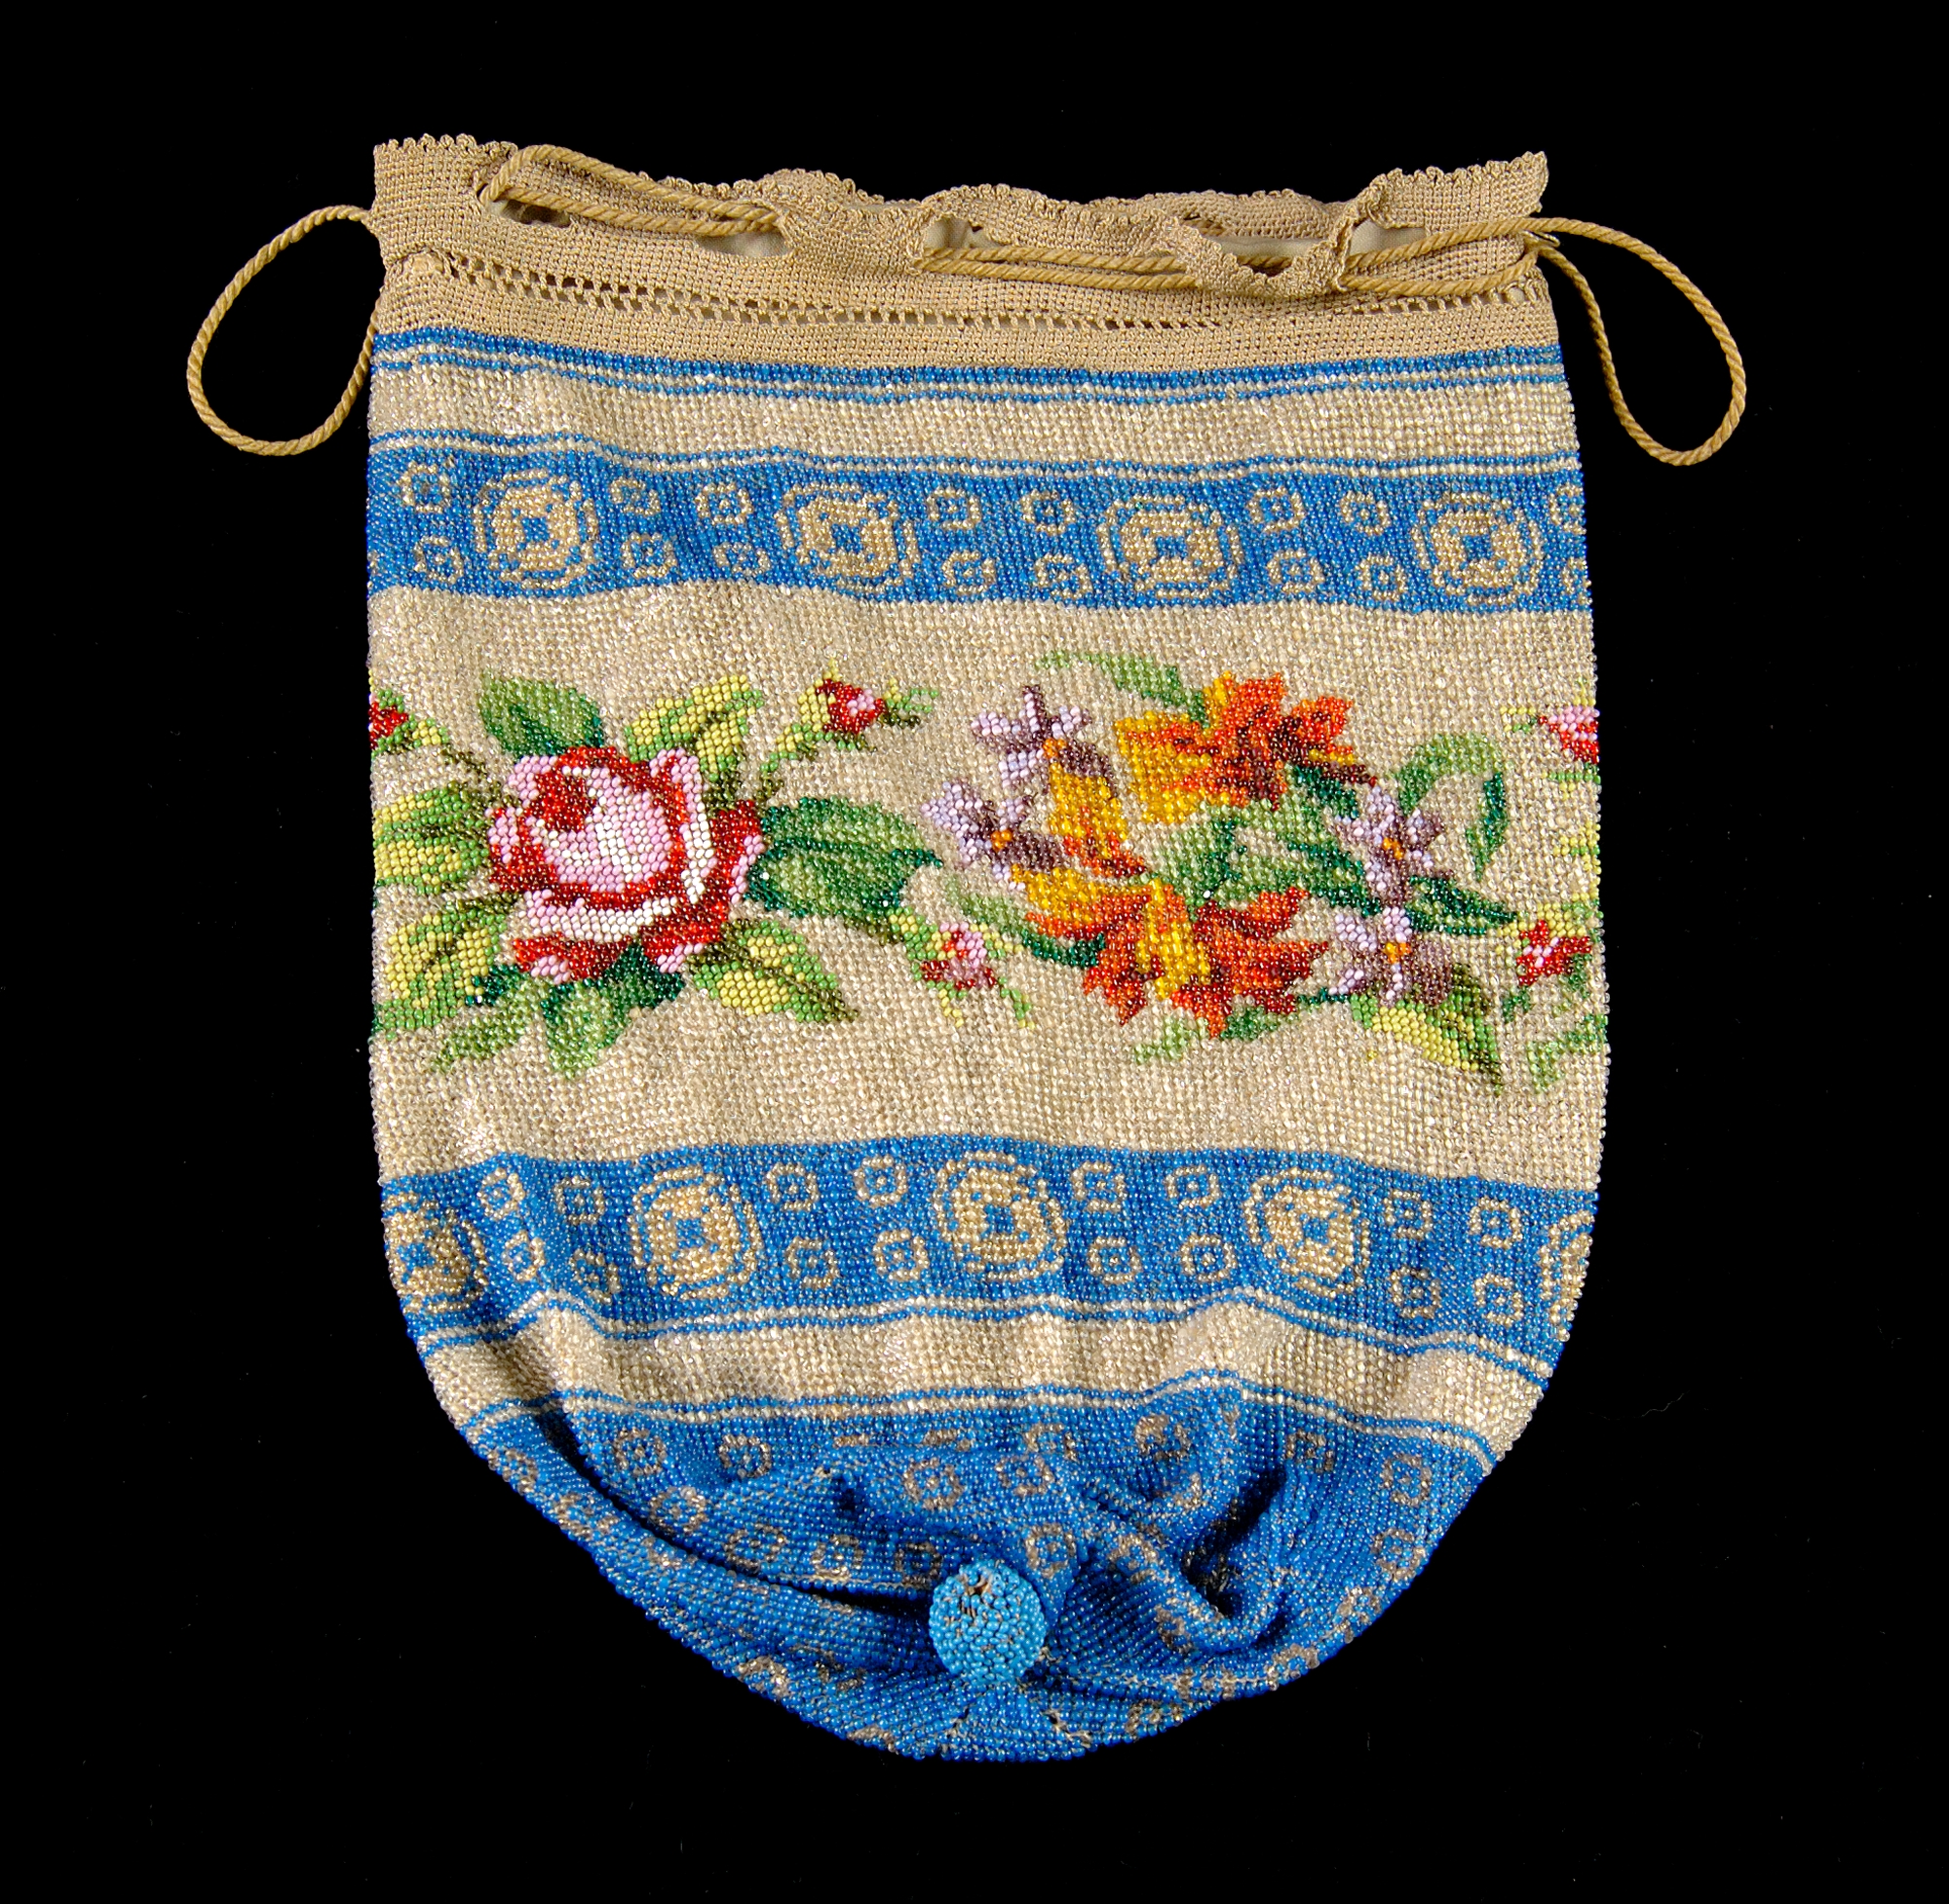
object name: pouch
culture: american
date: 1851-1875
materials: cotton, glass, linen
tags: flowers